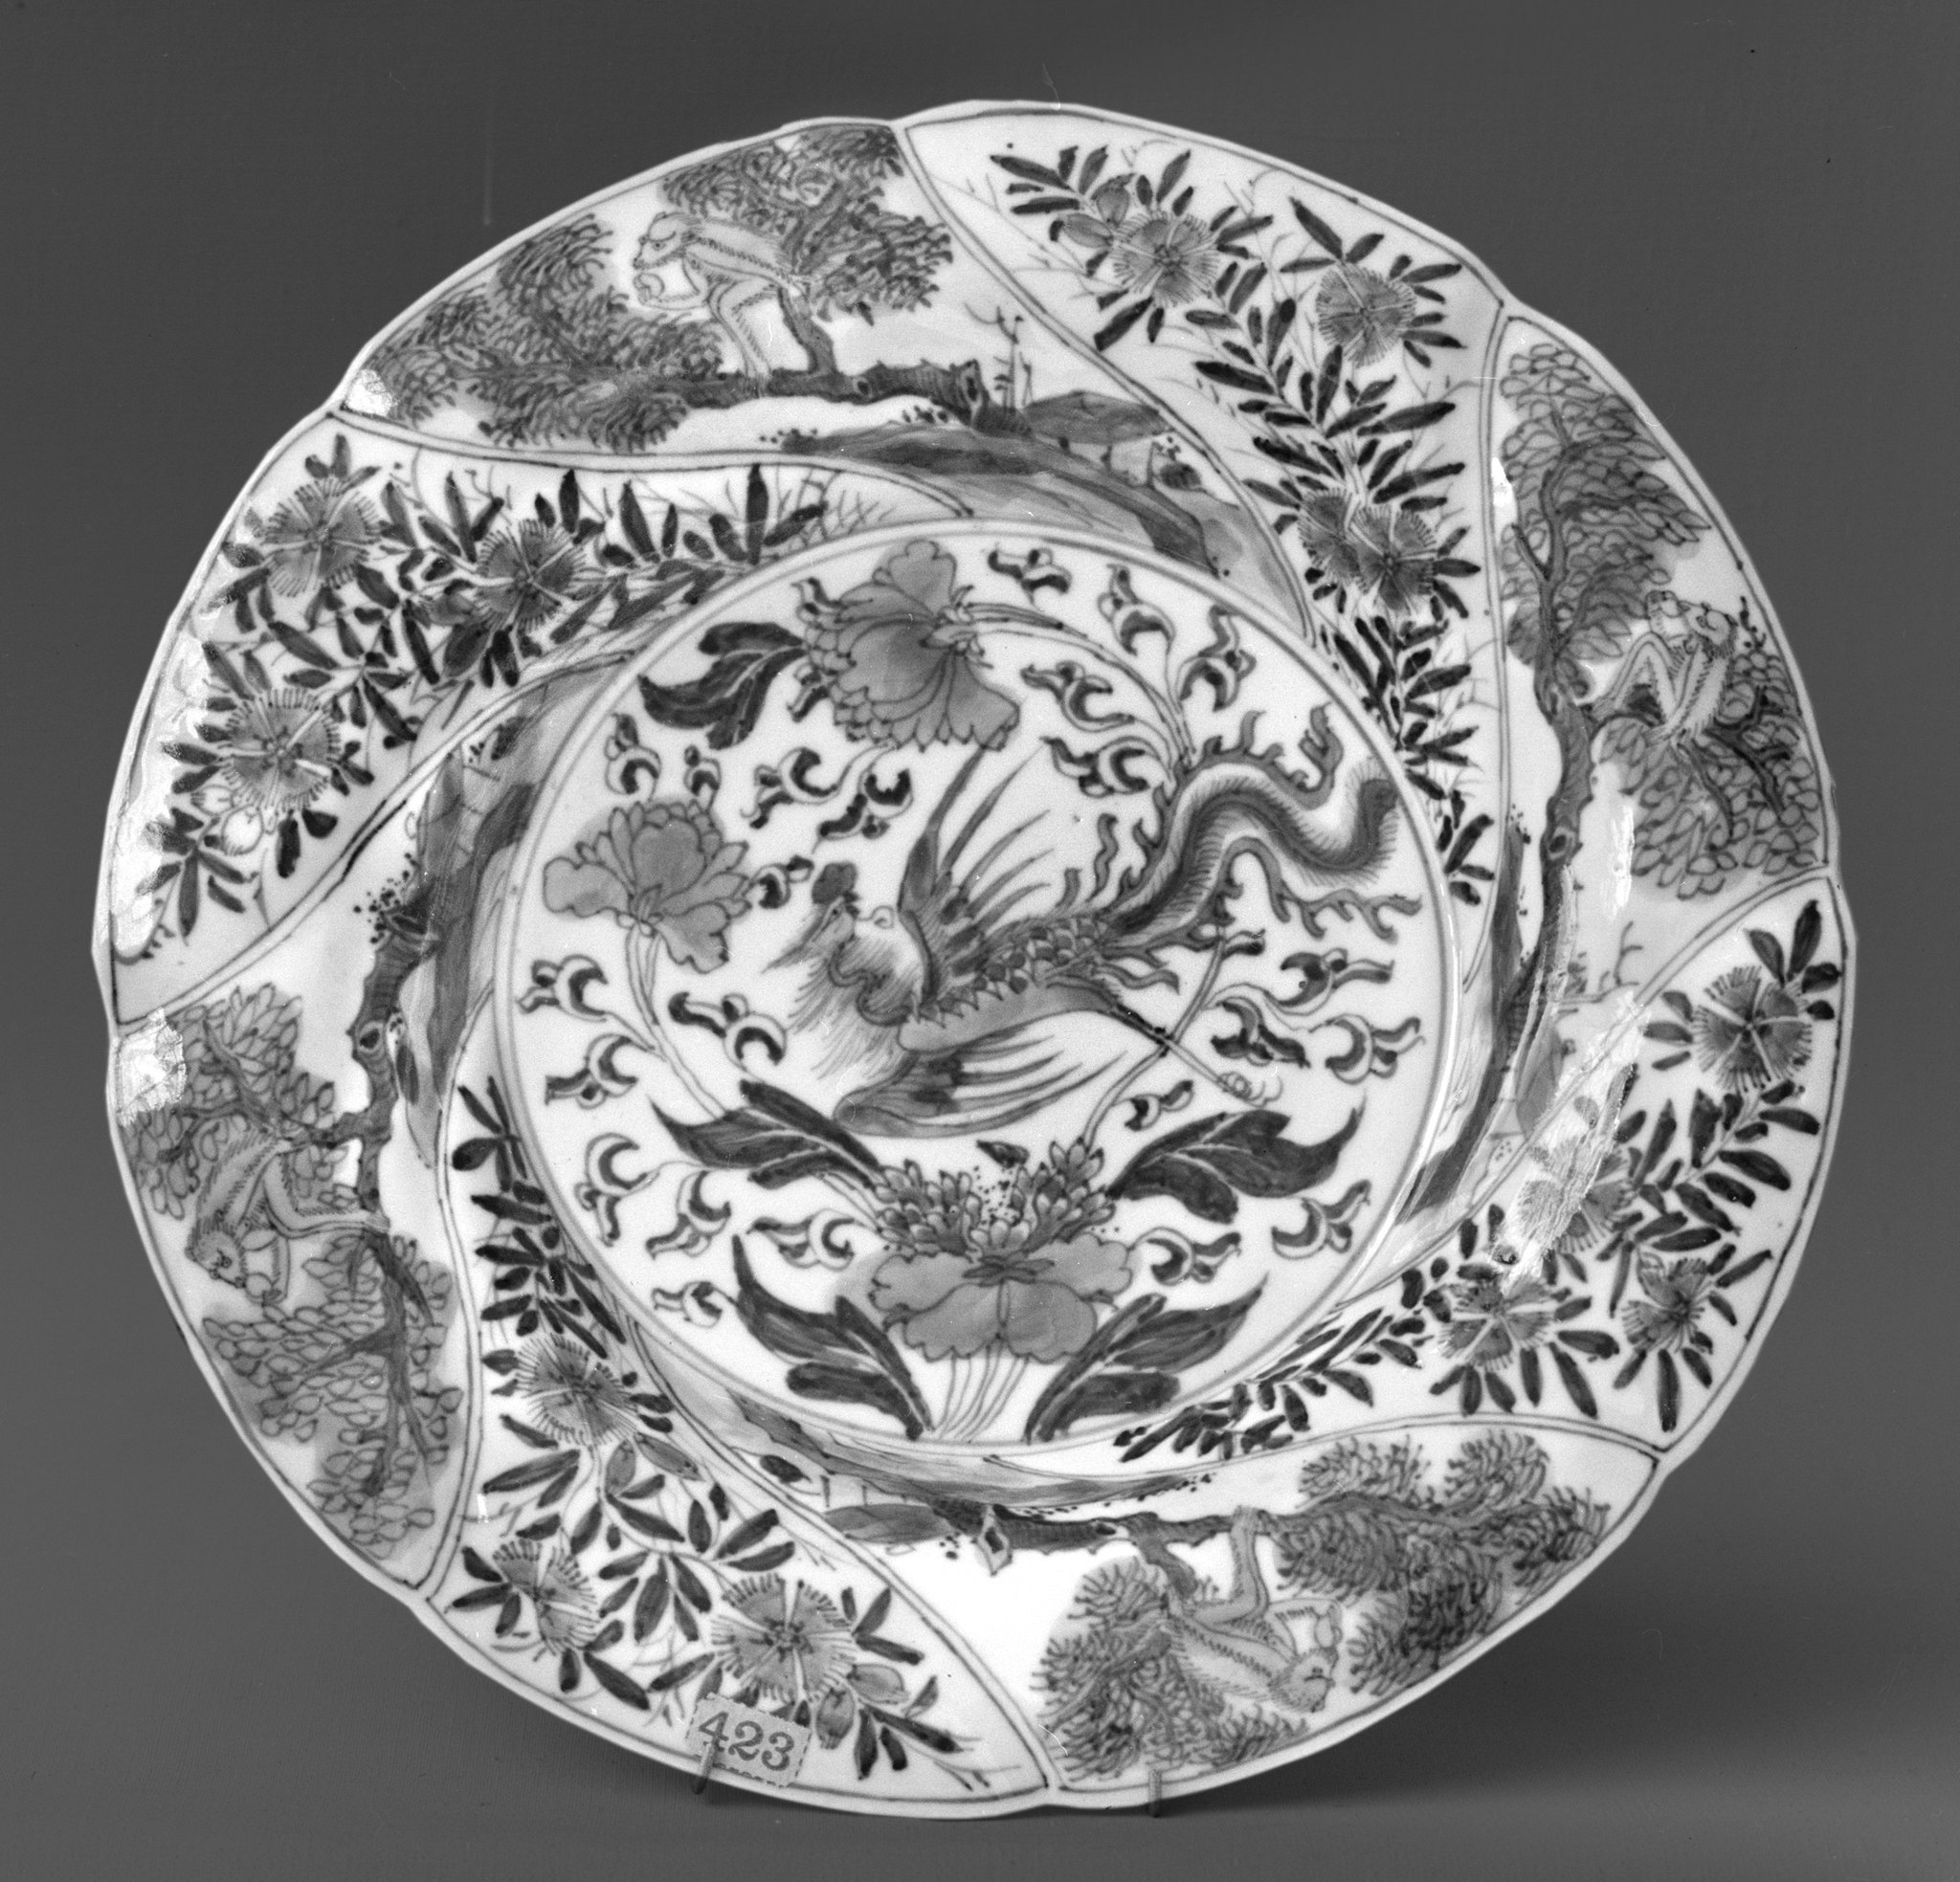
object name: plate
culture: chinese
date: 1667-1733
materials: porcelain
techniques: painting, underglaze